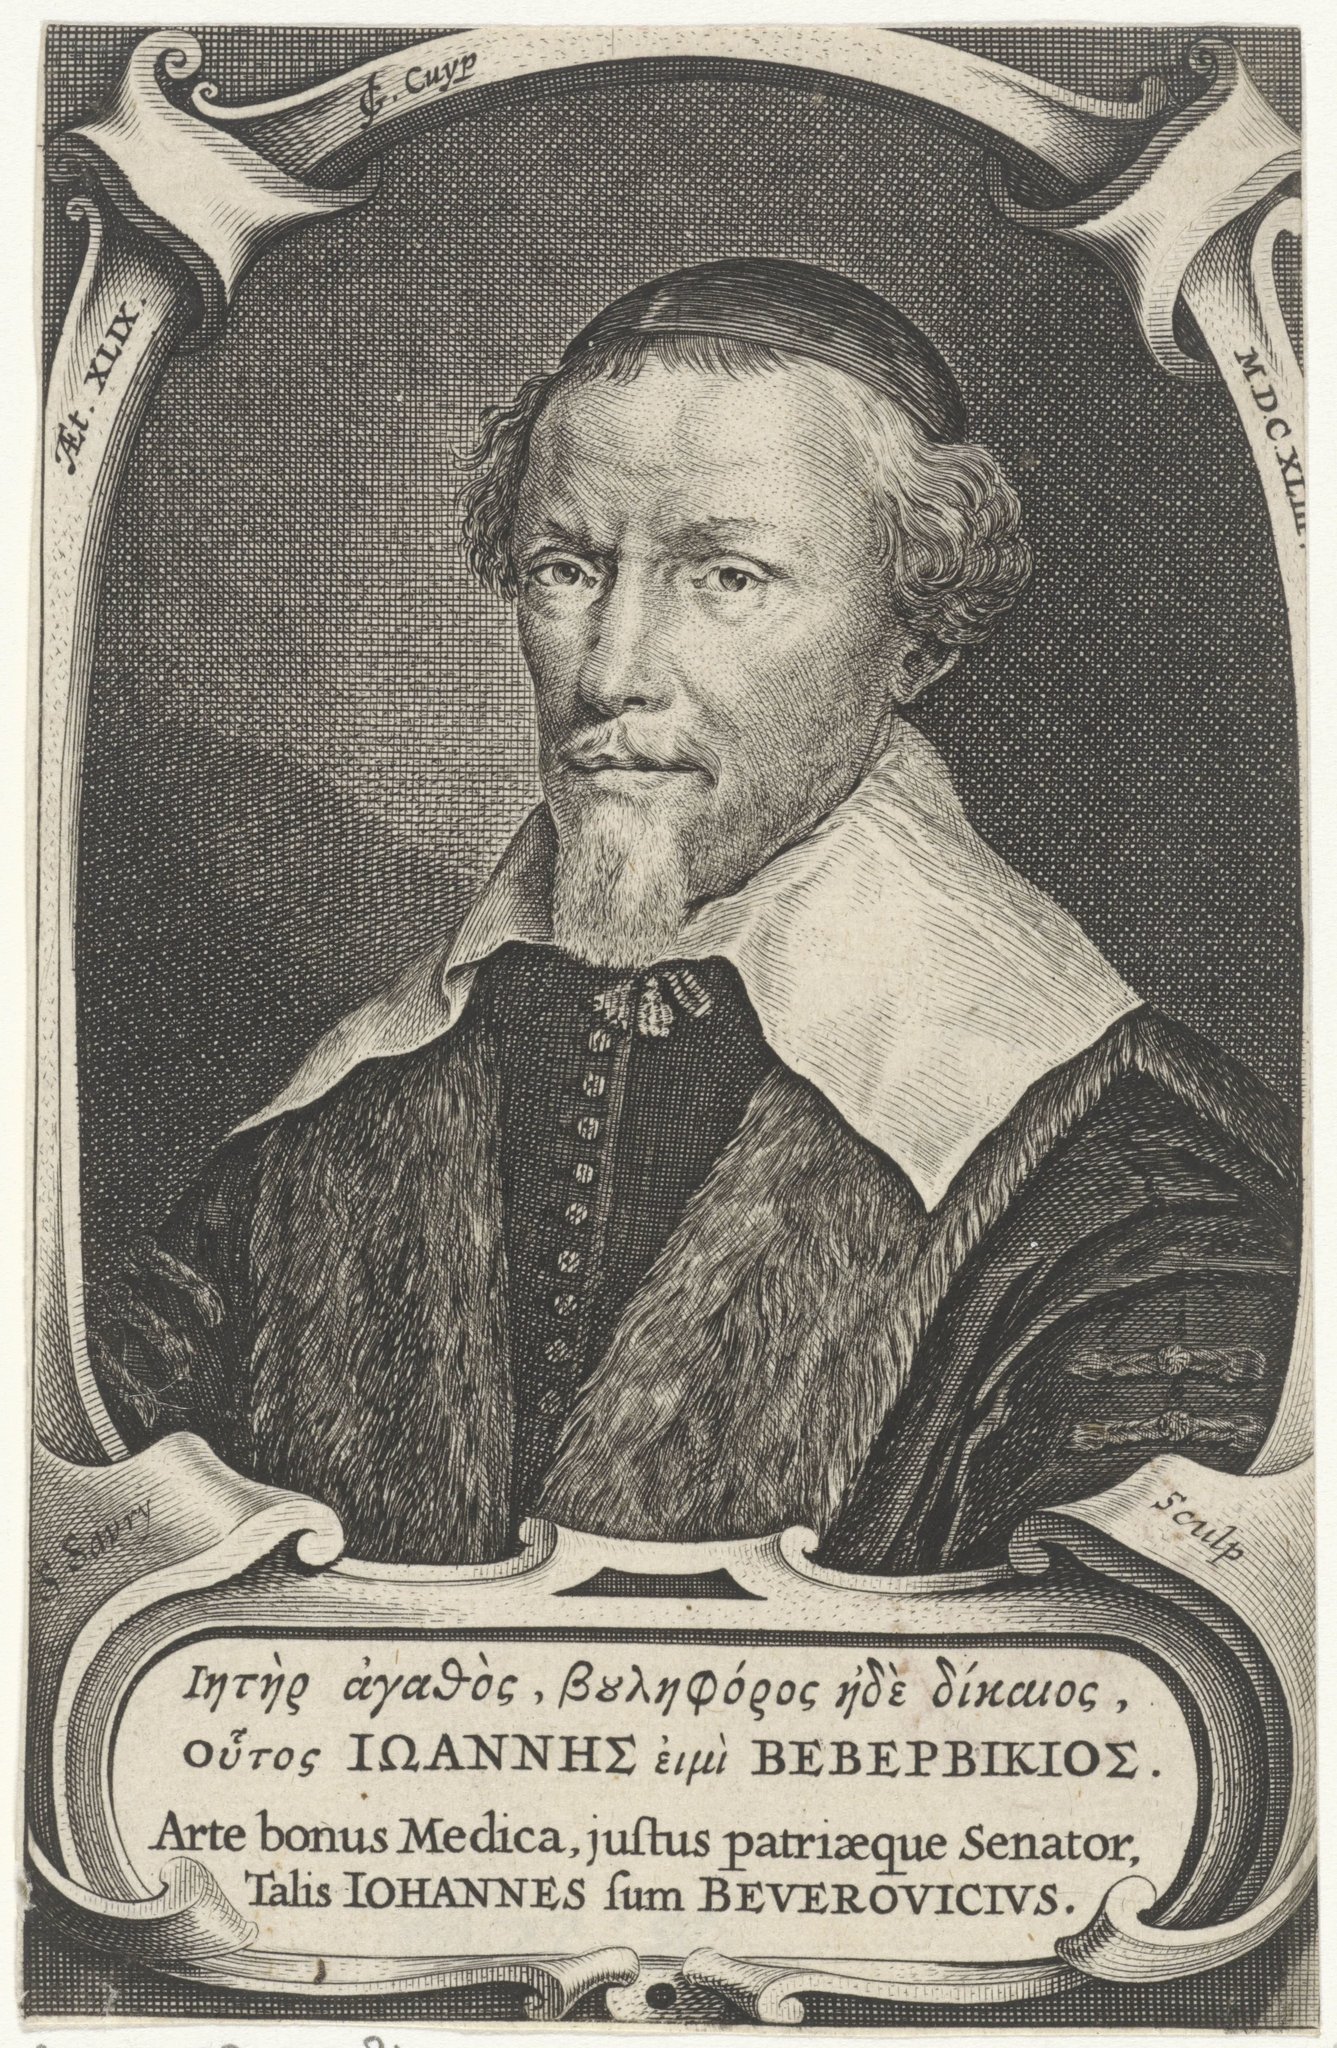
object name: print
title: Portret van Johannes van Beverwijck, arts en schrijver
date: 1643-1650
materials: paper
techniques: engraving, etching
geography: amsterdam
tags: dordrecht, johan van beverwijck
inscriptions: collector's mark: Lugt 240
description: Portret opgenomen in: Beverwijck, Johan van. Schat der ongesontheyt, ofte Genees-konste van de sieckten. Dordrecht: Jacob Braat, 1650.